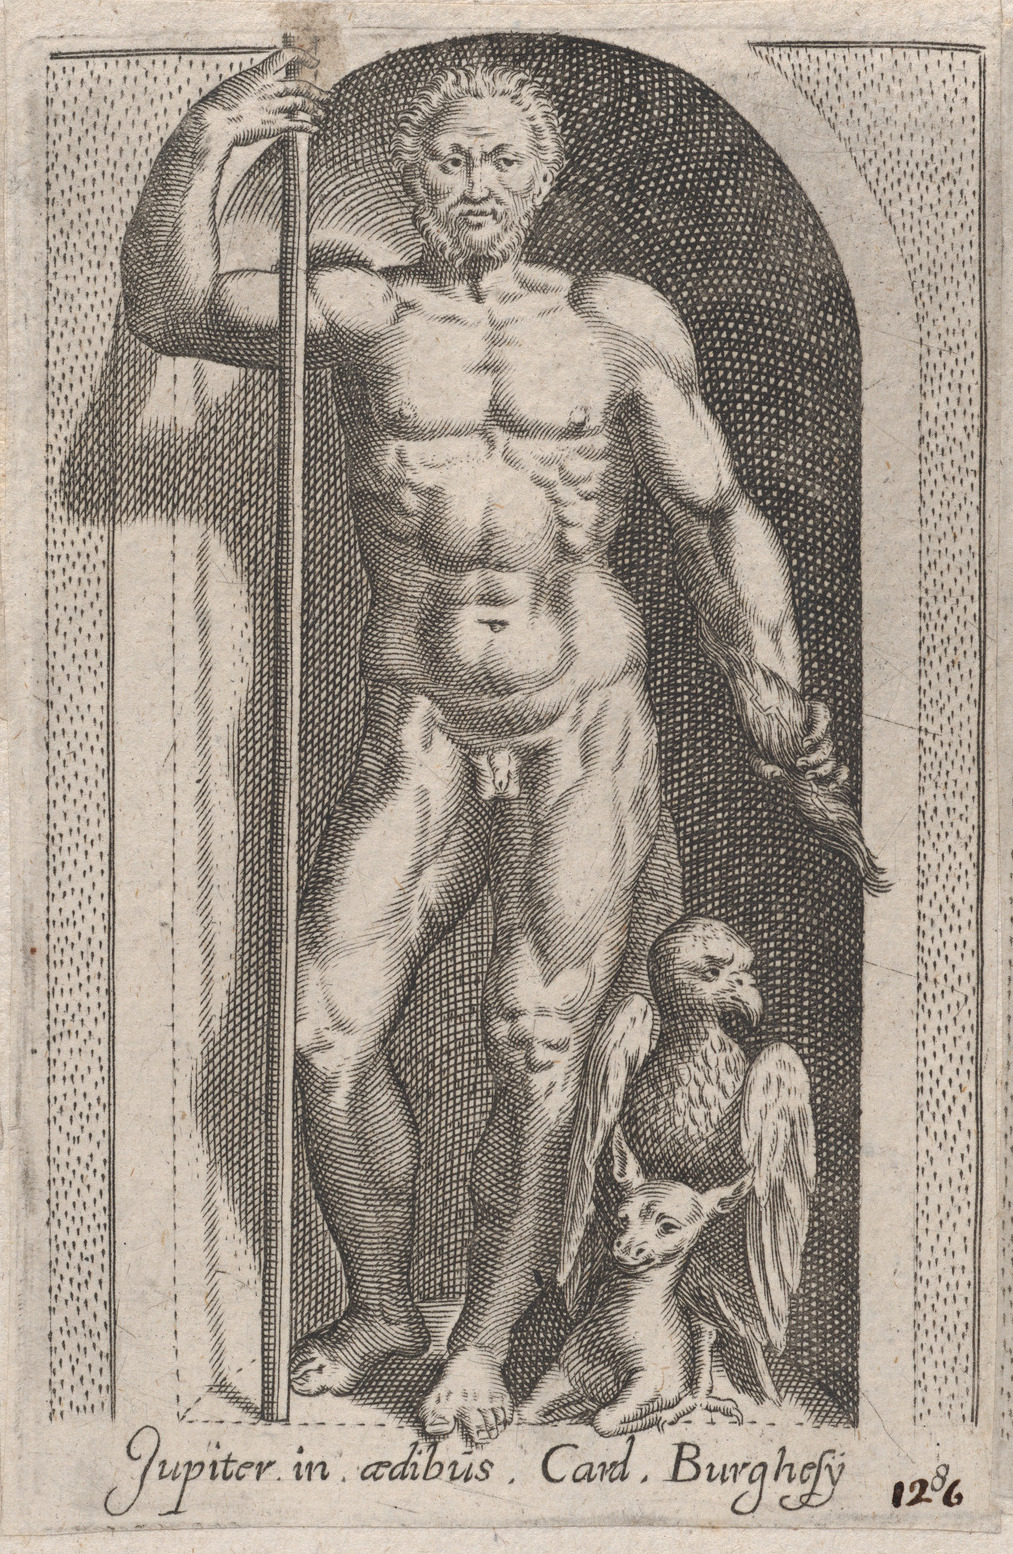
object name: print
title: Jupiter (Jupiter in aedibus Card. Burghesij), from "Speculum Romanae Magnificentiae"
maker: Anonymous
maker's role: artist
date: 1501-1600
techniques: engraving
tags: animals,birds,jupiter